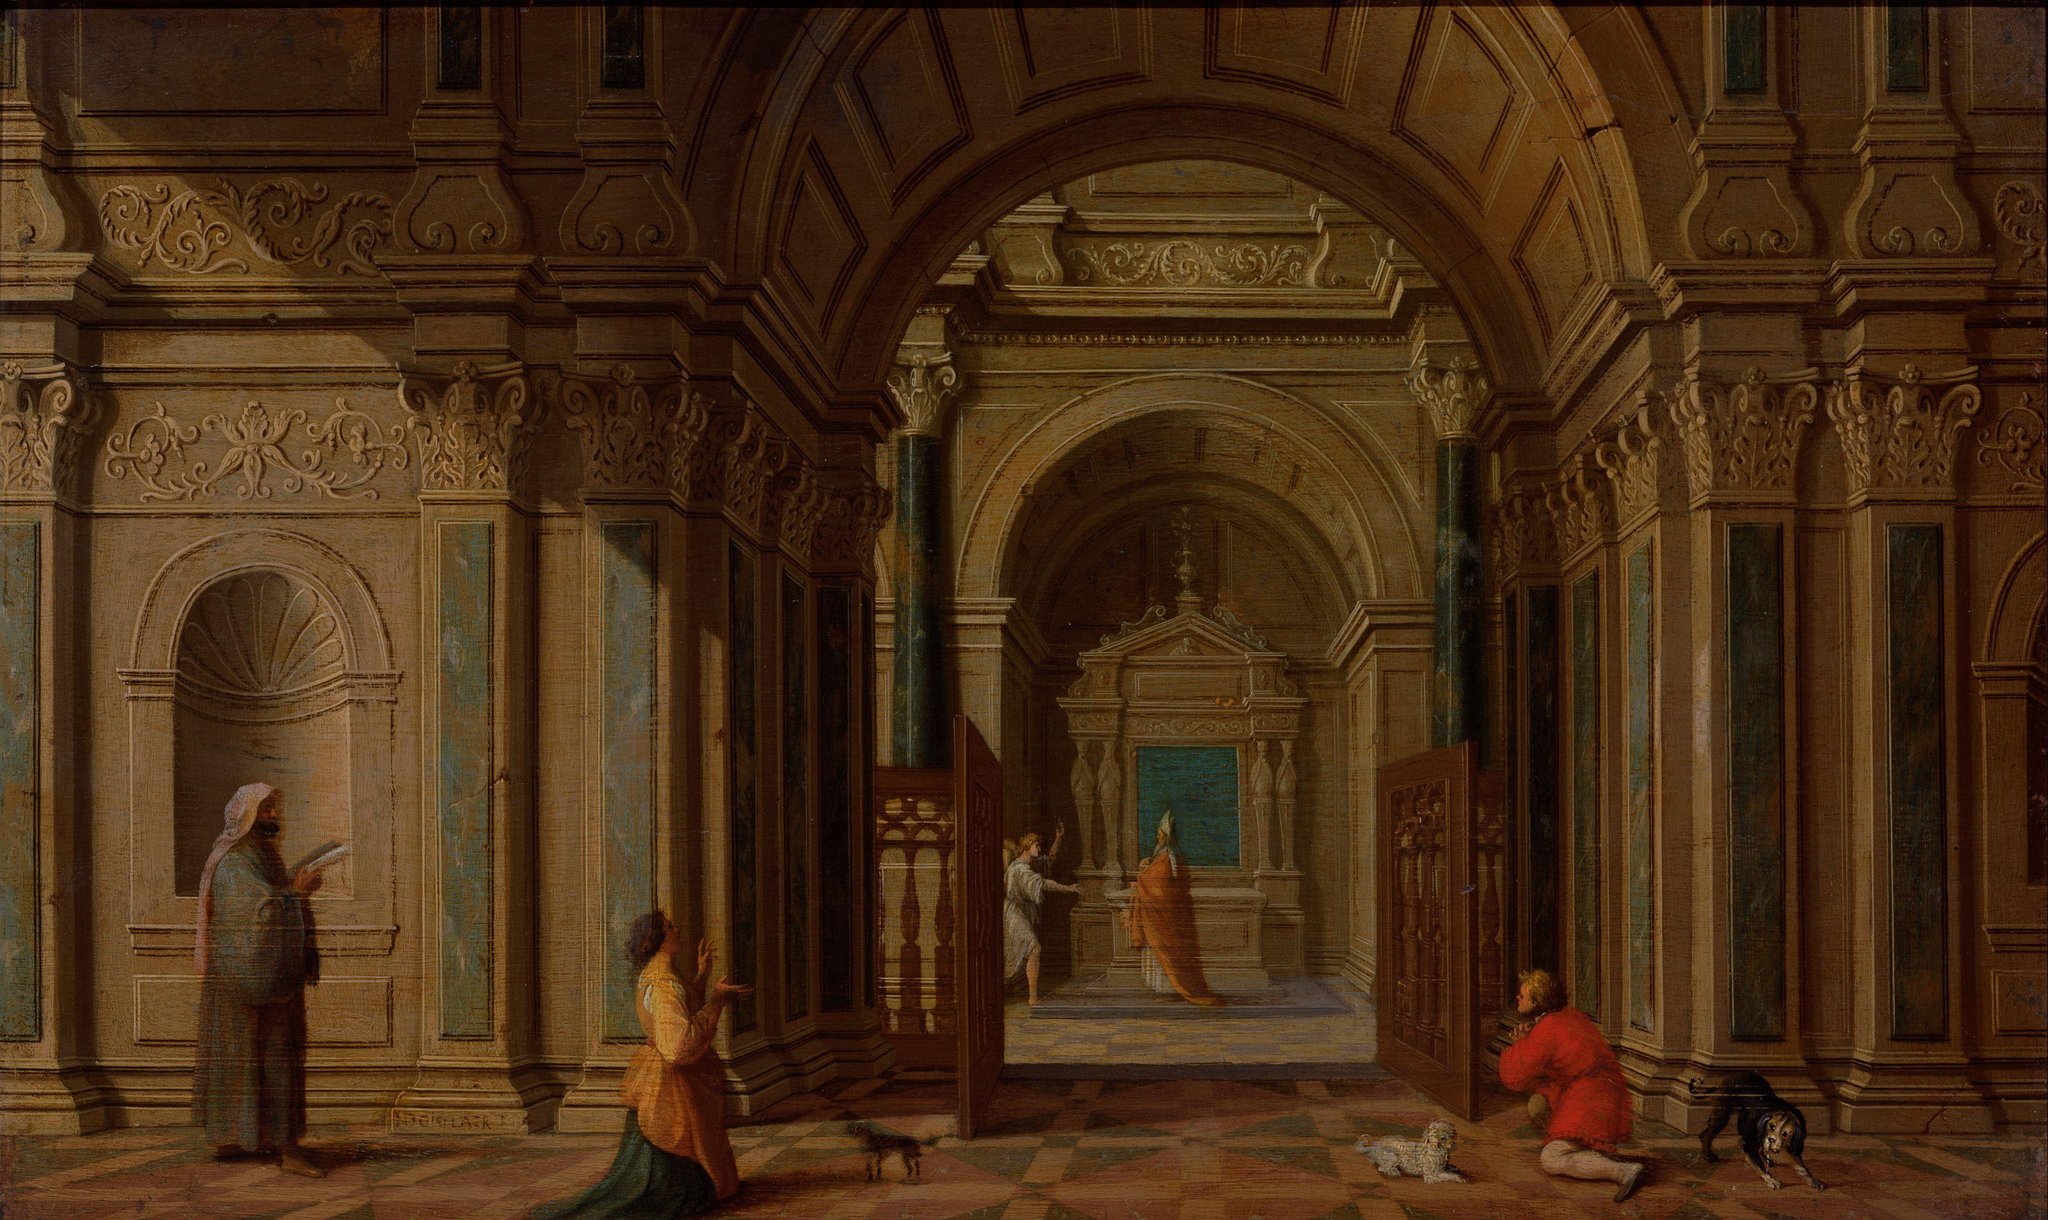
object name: painting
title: The Archangel Gabriel Appearing to Zacharias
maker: nicolaes de giselaer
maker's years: 1583-1646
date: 1625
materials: oil, panel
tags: interior of church, annunciation of the birth of john the baptist to zacharias: while he is offering incense in the temple an angel (gabriel) appears to him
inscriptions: signature and date, lower left on the base of the column (N and D ligated): ‘1625 / ND GIS[.]LAER F[...].’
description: Kerkinterieur waarin de aartsengel Gabriël verschijnt aan Zacharias (Lucas 1:11) bij het altaar. Op de voorgrond een staande man met een boek, een knielende man en vrouw en enkele honden.